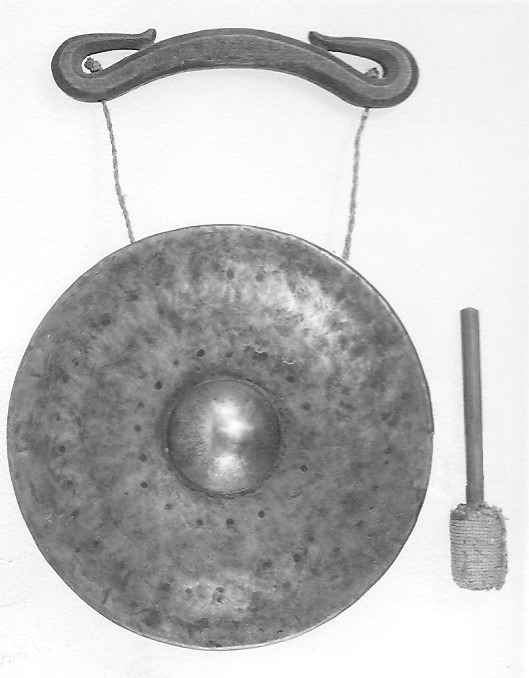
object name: klong mēng ฆ องเหม ง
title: Klong mēng (ฆ้องเหม่ง)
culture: thai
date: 1867-1900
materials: brass, wood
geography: thailand